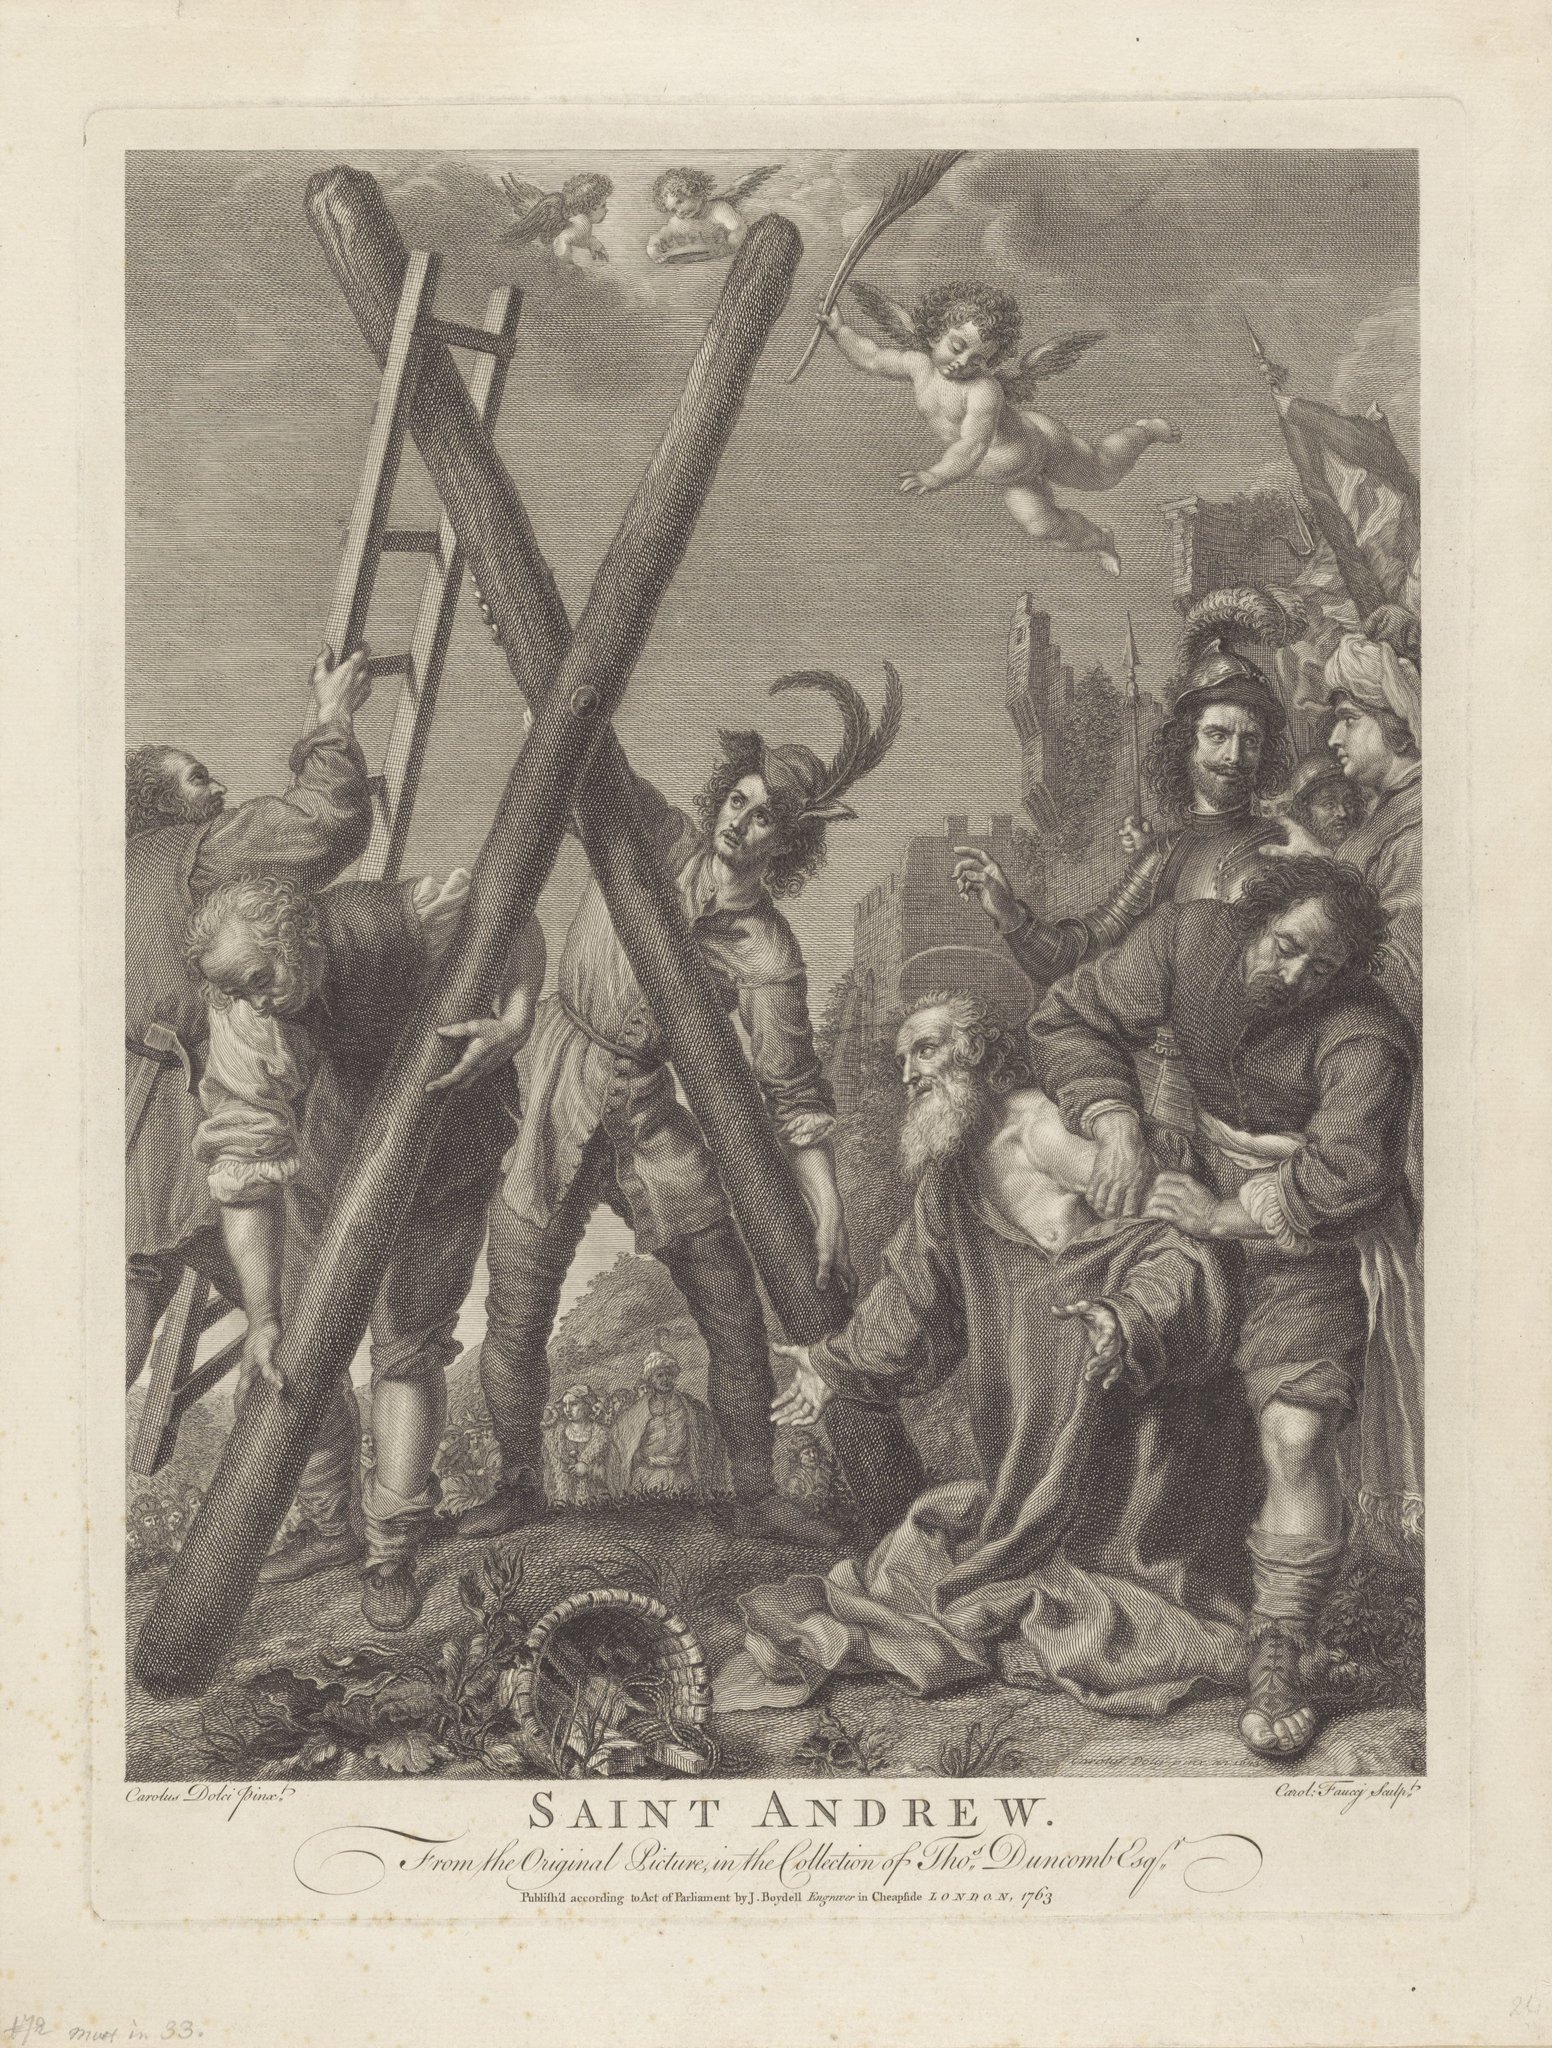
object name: print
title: De heilige Andreas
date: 1763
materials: paper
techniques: engraving, etching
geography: london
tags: the apostle andrew; possible attributes: book, x-shaped cross, fish, fishing-net, rope, scroll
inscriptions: collector's mark: Lugt 2165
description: De heilige Andreas zit geknield in een landschap. Een man ontdoet hem van zijn gewaad. Andere mannen richten een kruis op, waaraan Andreas spoedig gekruisigd zal worden. Andere figuren kijken toe. In de lucht drie putti. Tekst in ondermarge.